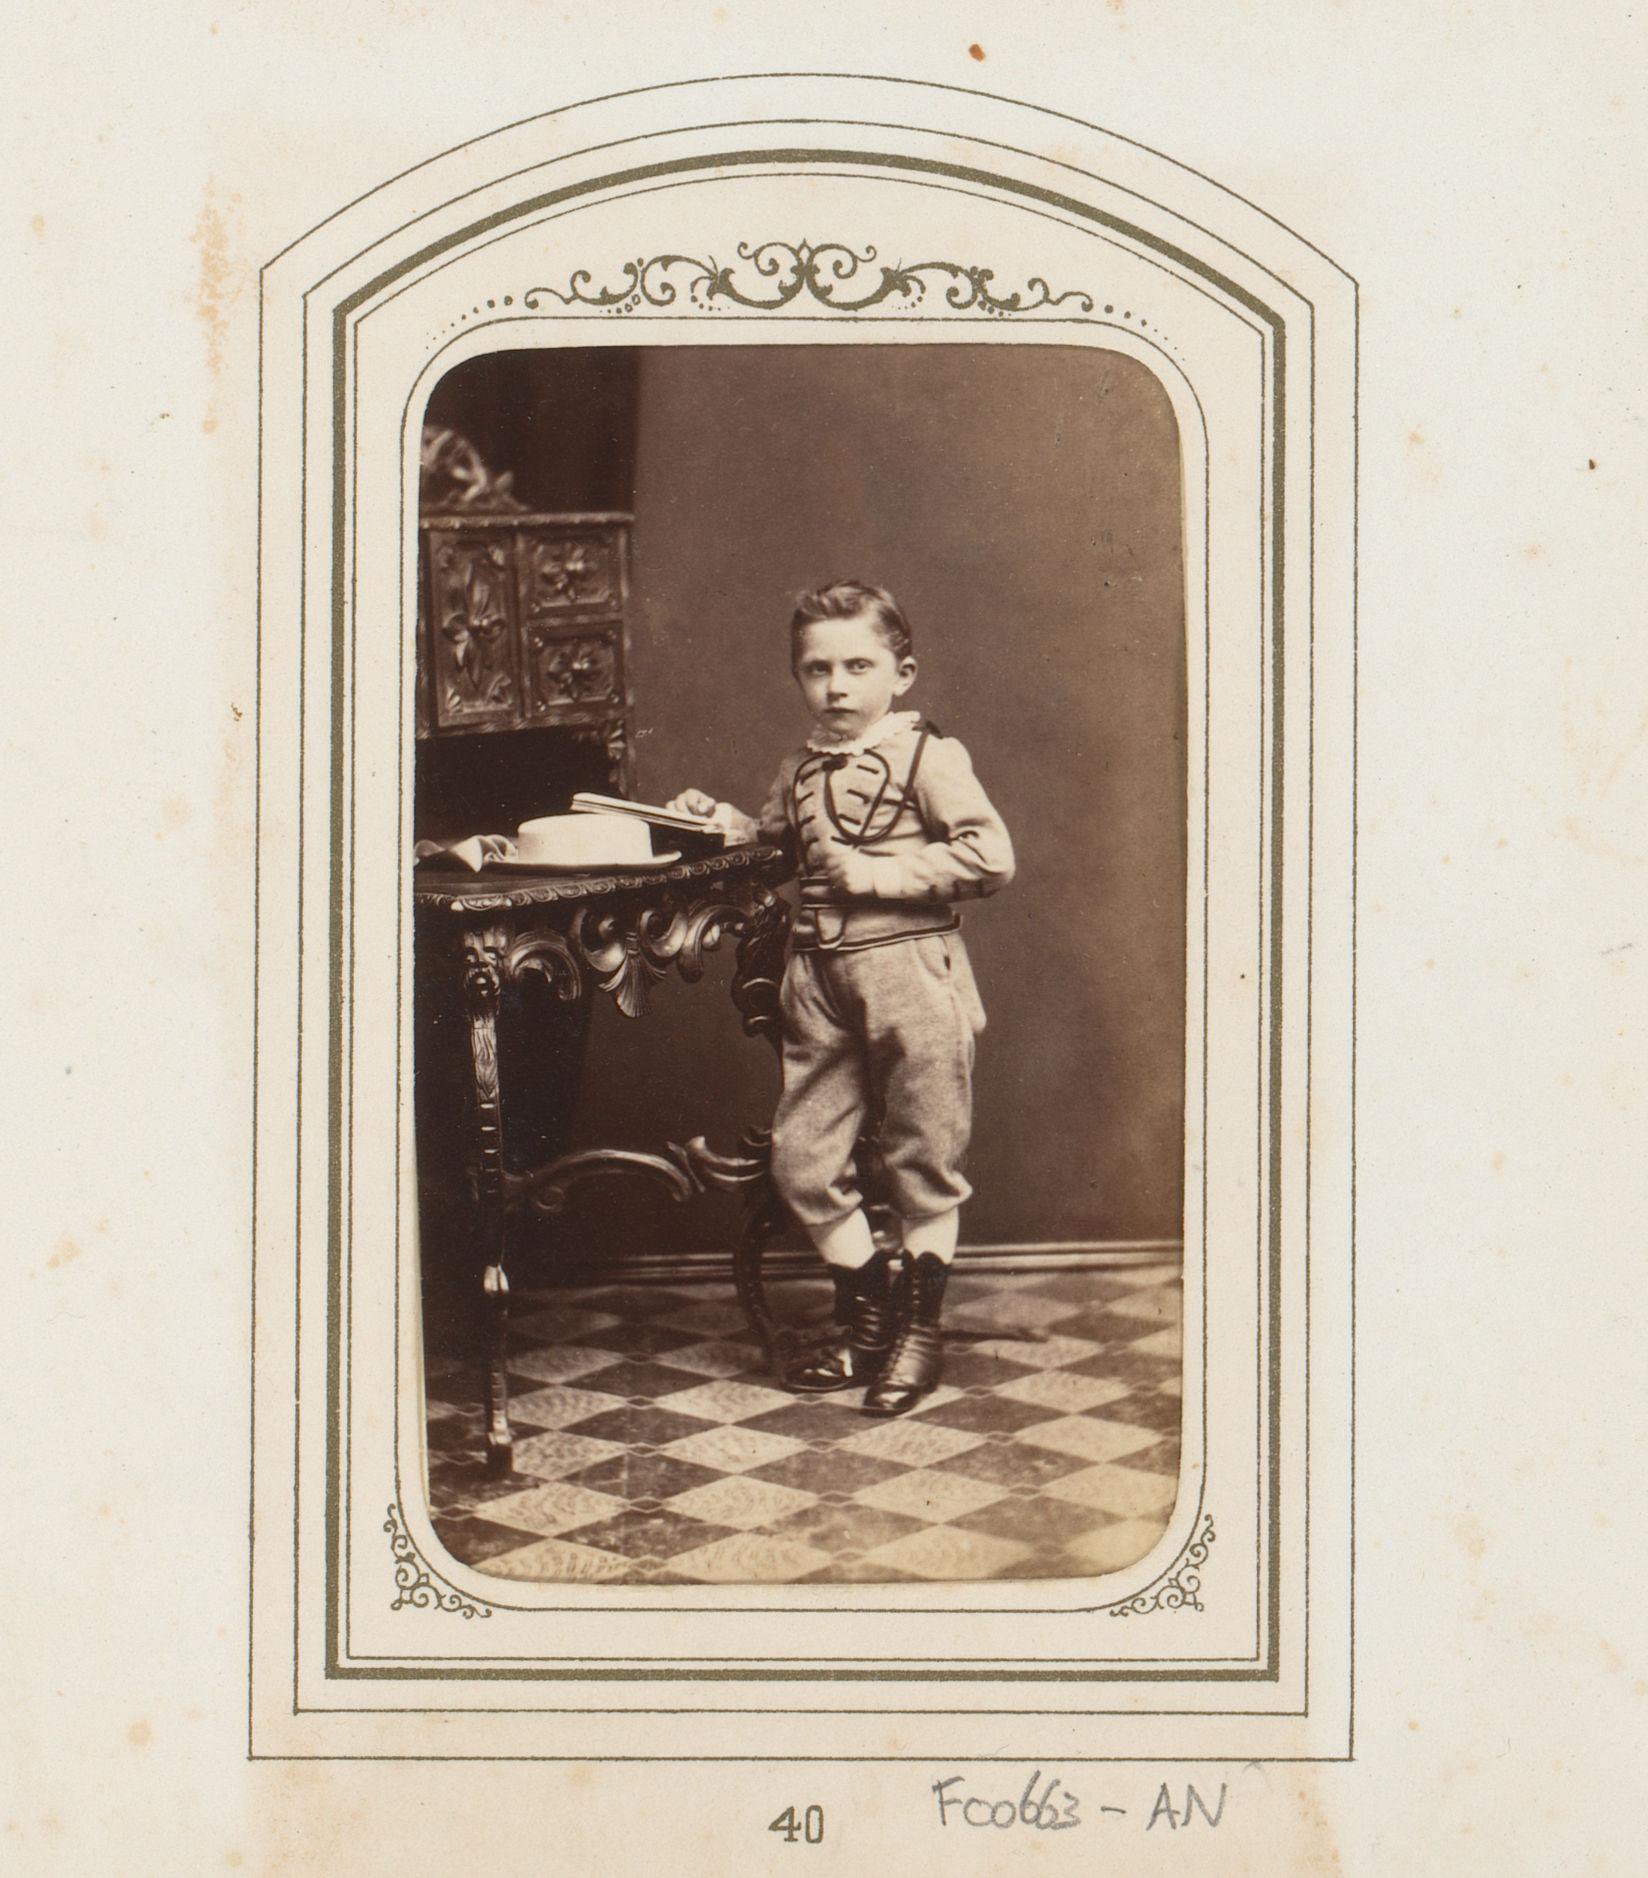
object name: photograph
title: Portret van een staande jongen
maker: hendrik anthonie karel ringler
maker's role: draughtsman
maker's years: 1846-1879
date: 1872-1879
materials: cardboard, photographic support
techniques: albumen print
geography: leeuwarden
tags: boy (child between toddler and youth), historical persons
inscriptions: inscription: ‘H.A.K. Ringler/ Weststraat bij het Zaailand/ Leeuwarden’, number: ‘40’